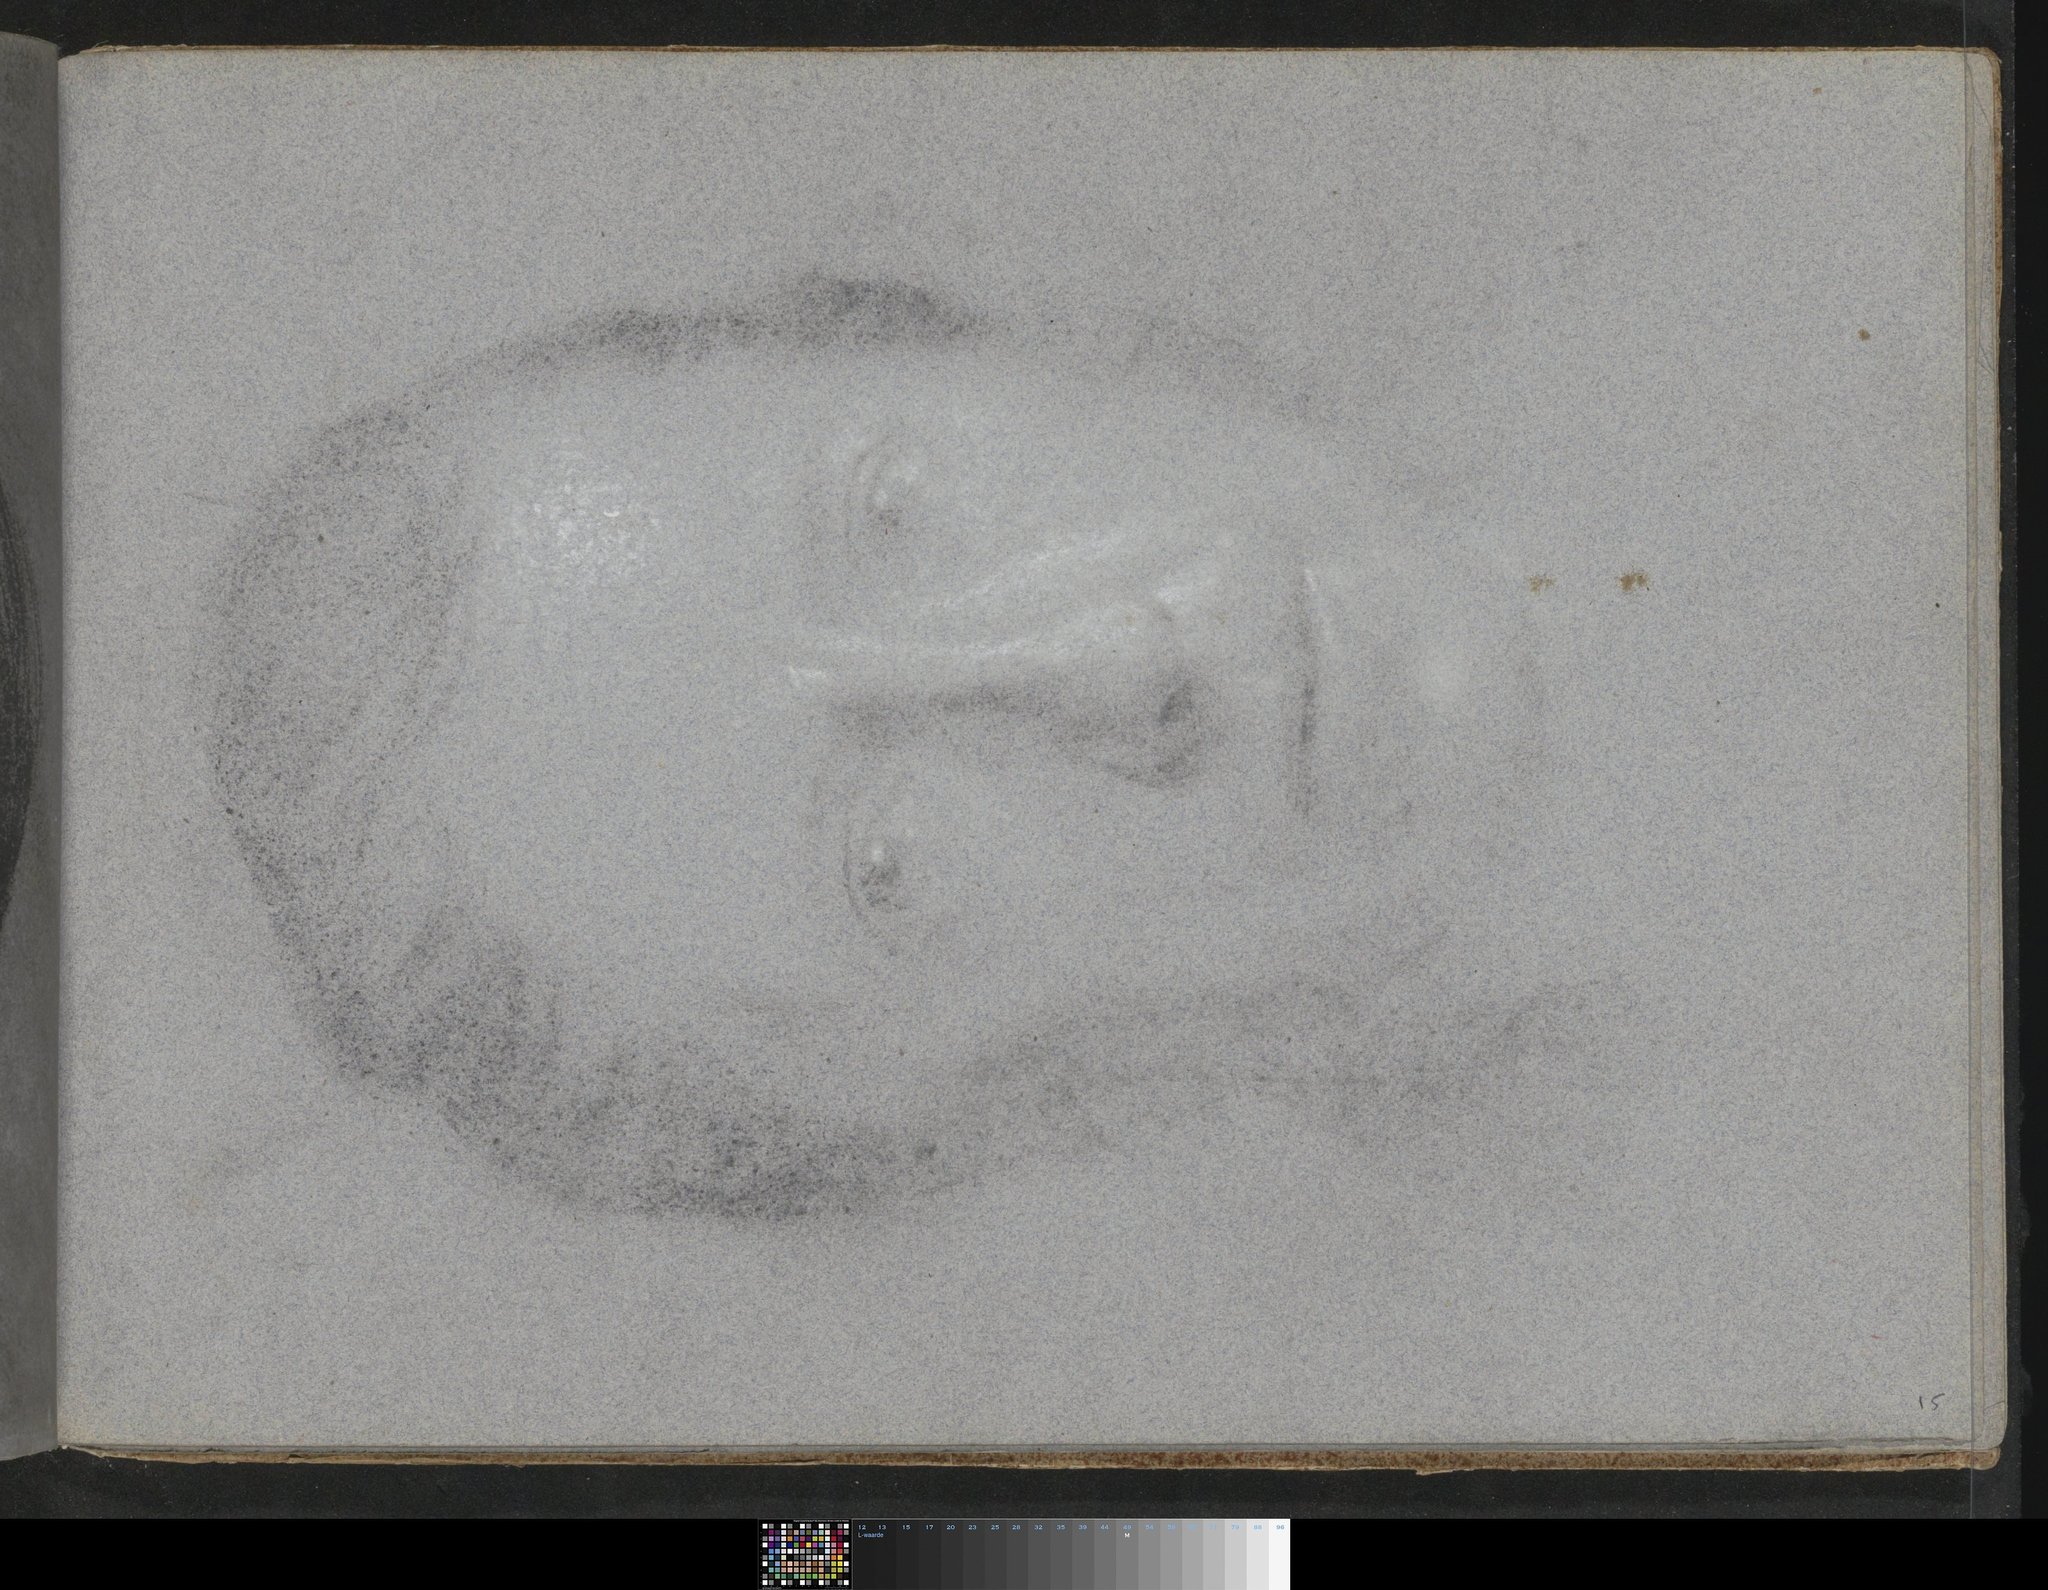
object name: sketchbook leaf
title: Abklatsch van de krijttekening op blad 14 verso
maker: s. altmann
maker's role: painter, print maker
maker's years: 1822-1890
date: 1803-1840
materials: paper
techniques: printmaking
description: Blad 15 recto uit een schetsboek met 24 bladen.